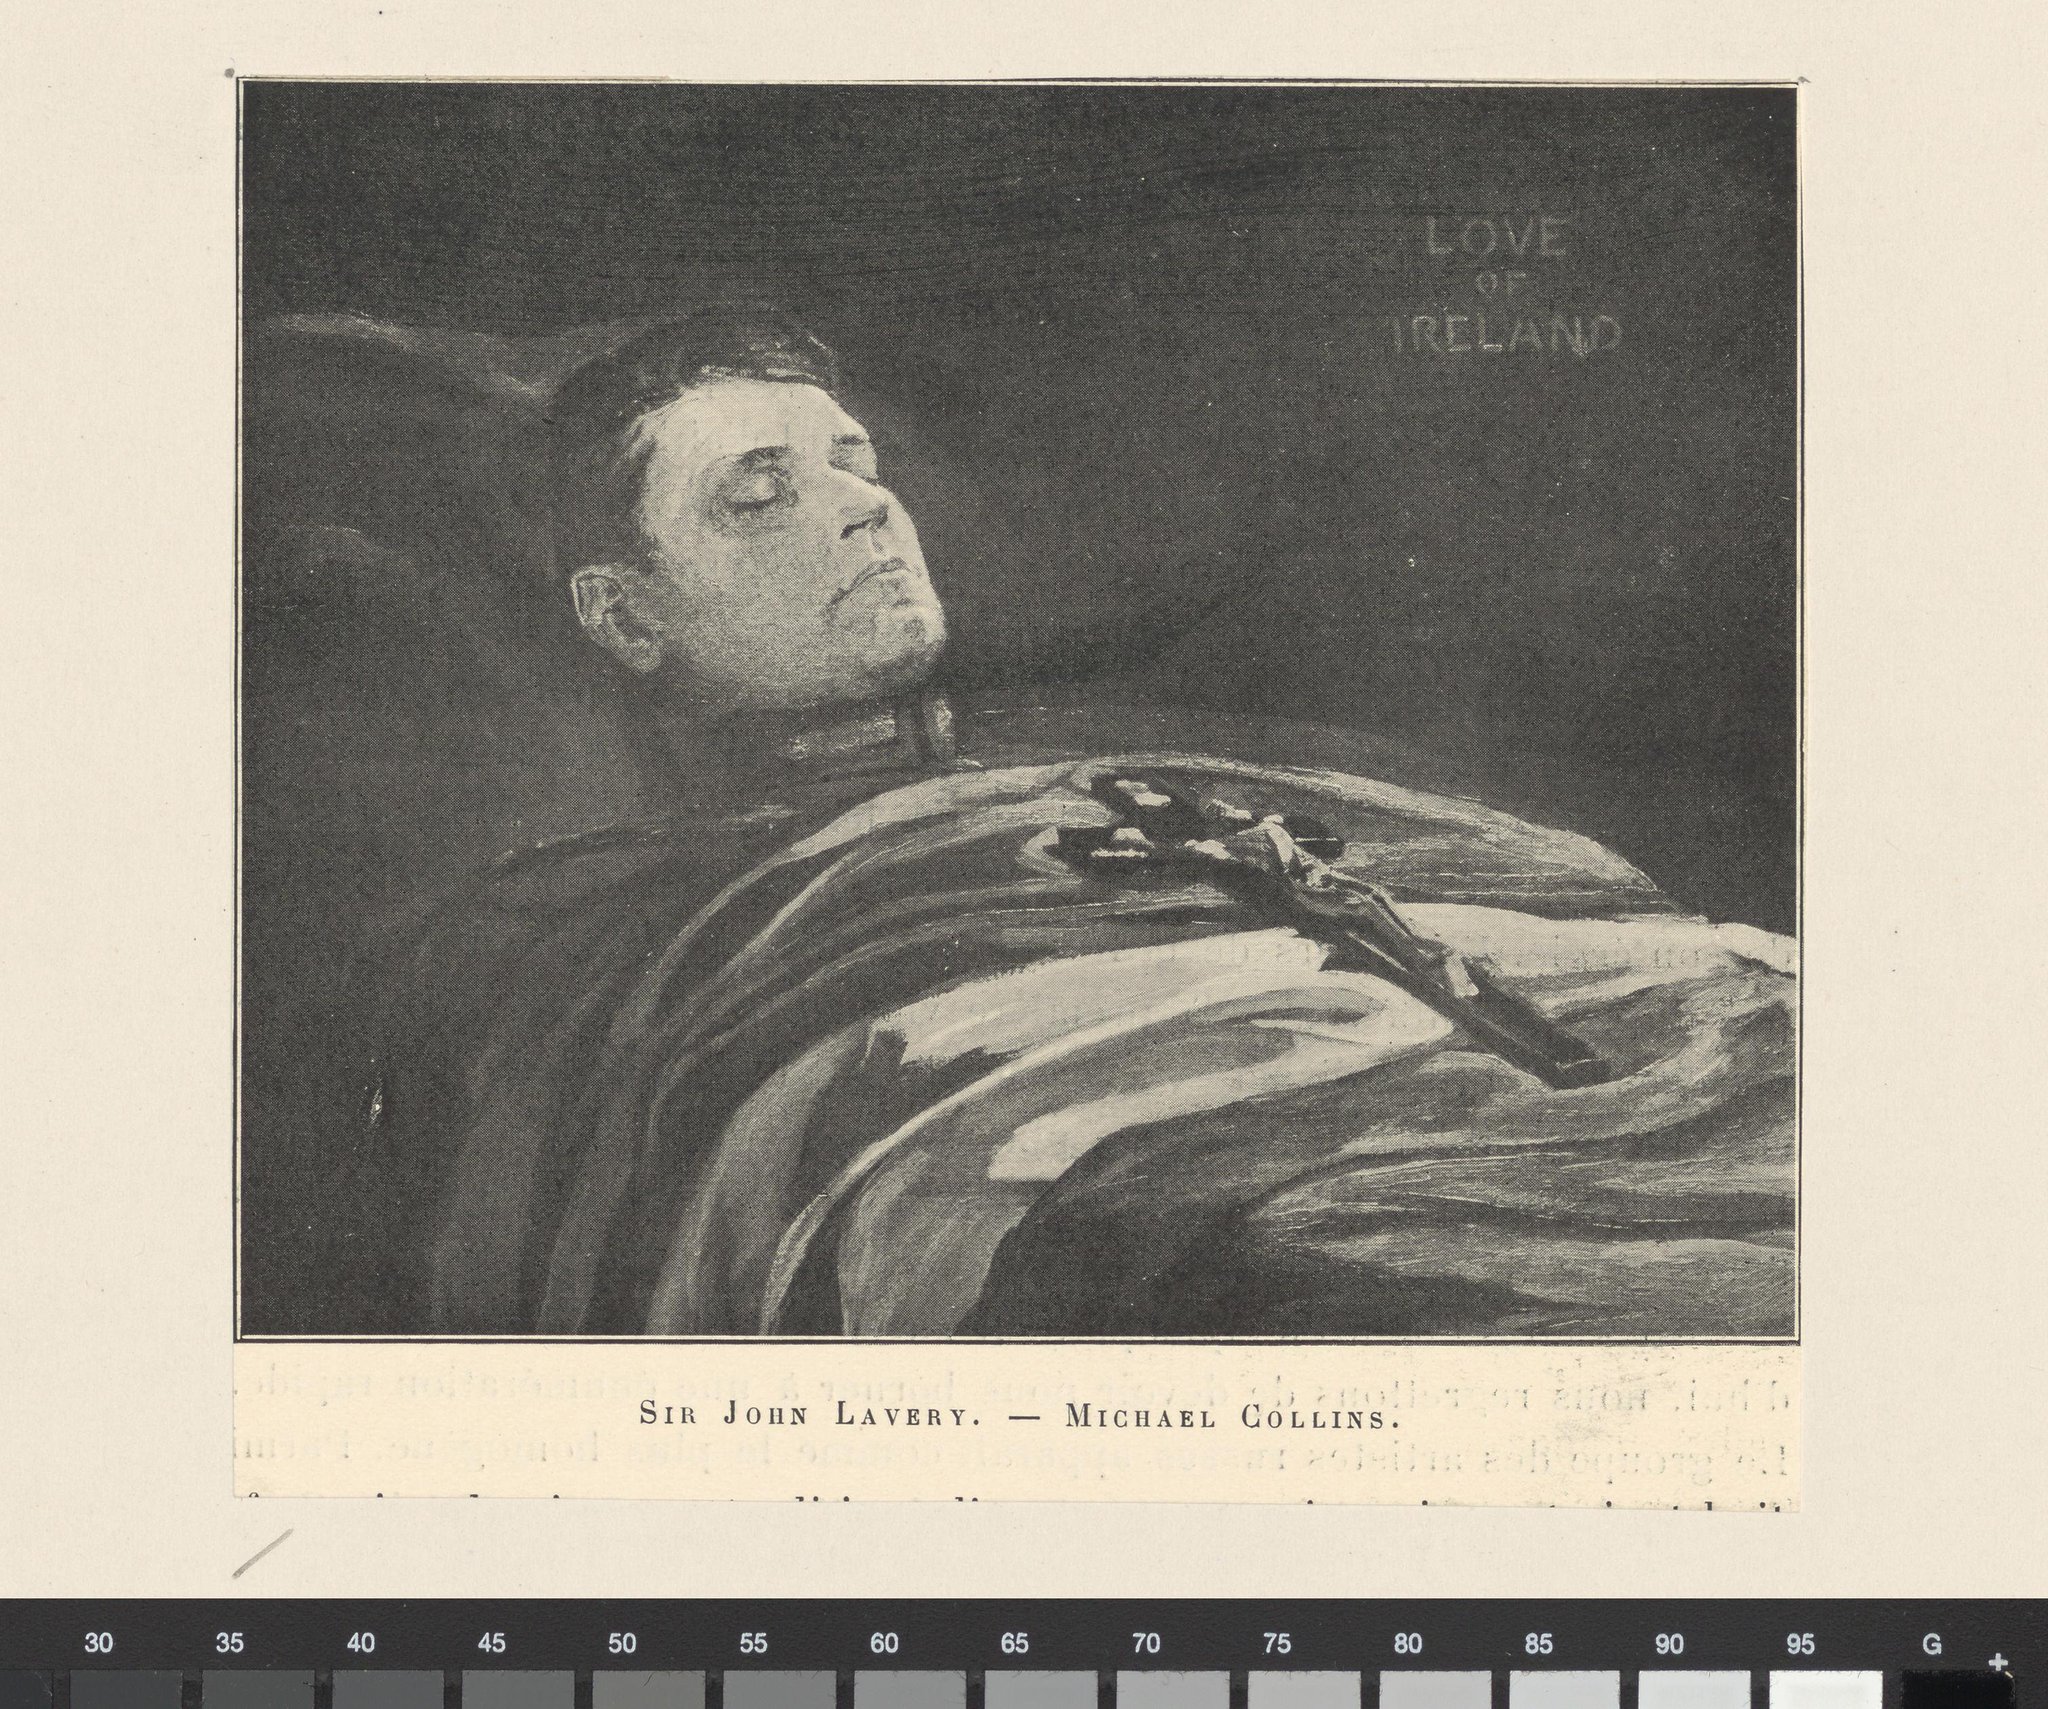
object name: photomechanical print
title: Portret van Michael Collins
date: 1922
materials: paper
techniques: letterpress printing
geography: paris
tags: politician, historical persons, politician, e.g. party leader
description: Prent uit: Revue de l'art ancien et moderne, nr. 42, 1922.